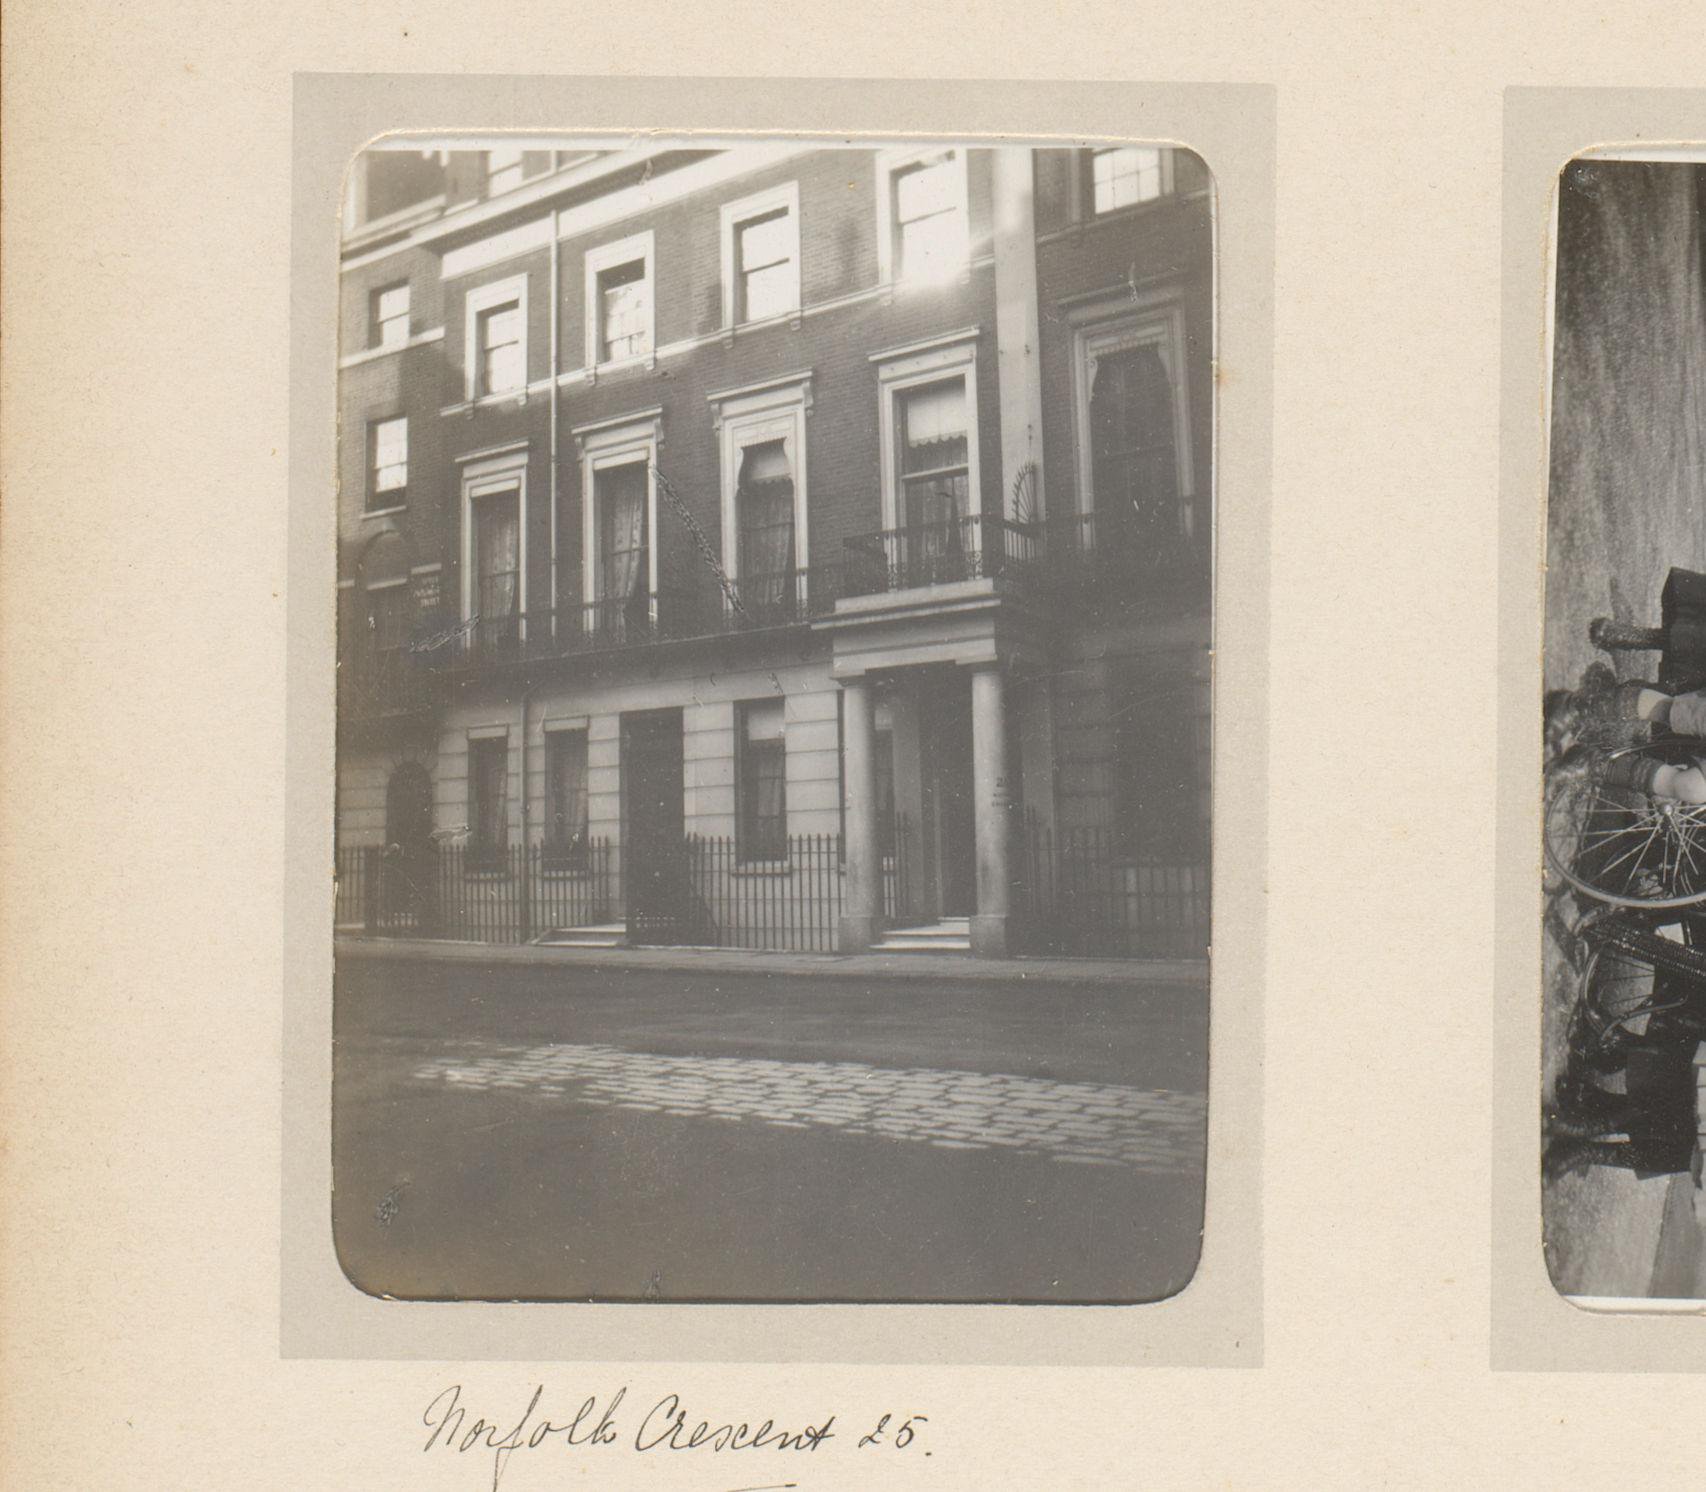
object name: album leaf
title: Gevel van Norfolk Crescent 25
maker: liesbeth overhoff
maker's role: fotograaf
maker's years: 1895-1969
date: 1912-1913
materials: paper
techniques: gelatin silver print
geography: london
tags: façade (of house or building)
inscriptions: inscription: ‘Norfolk Crescent 25.’